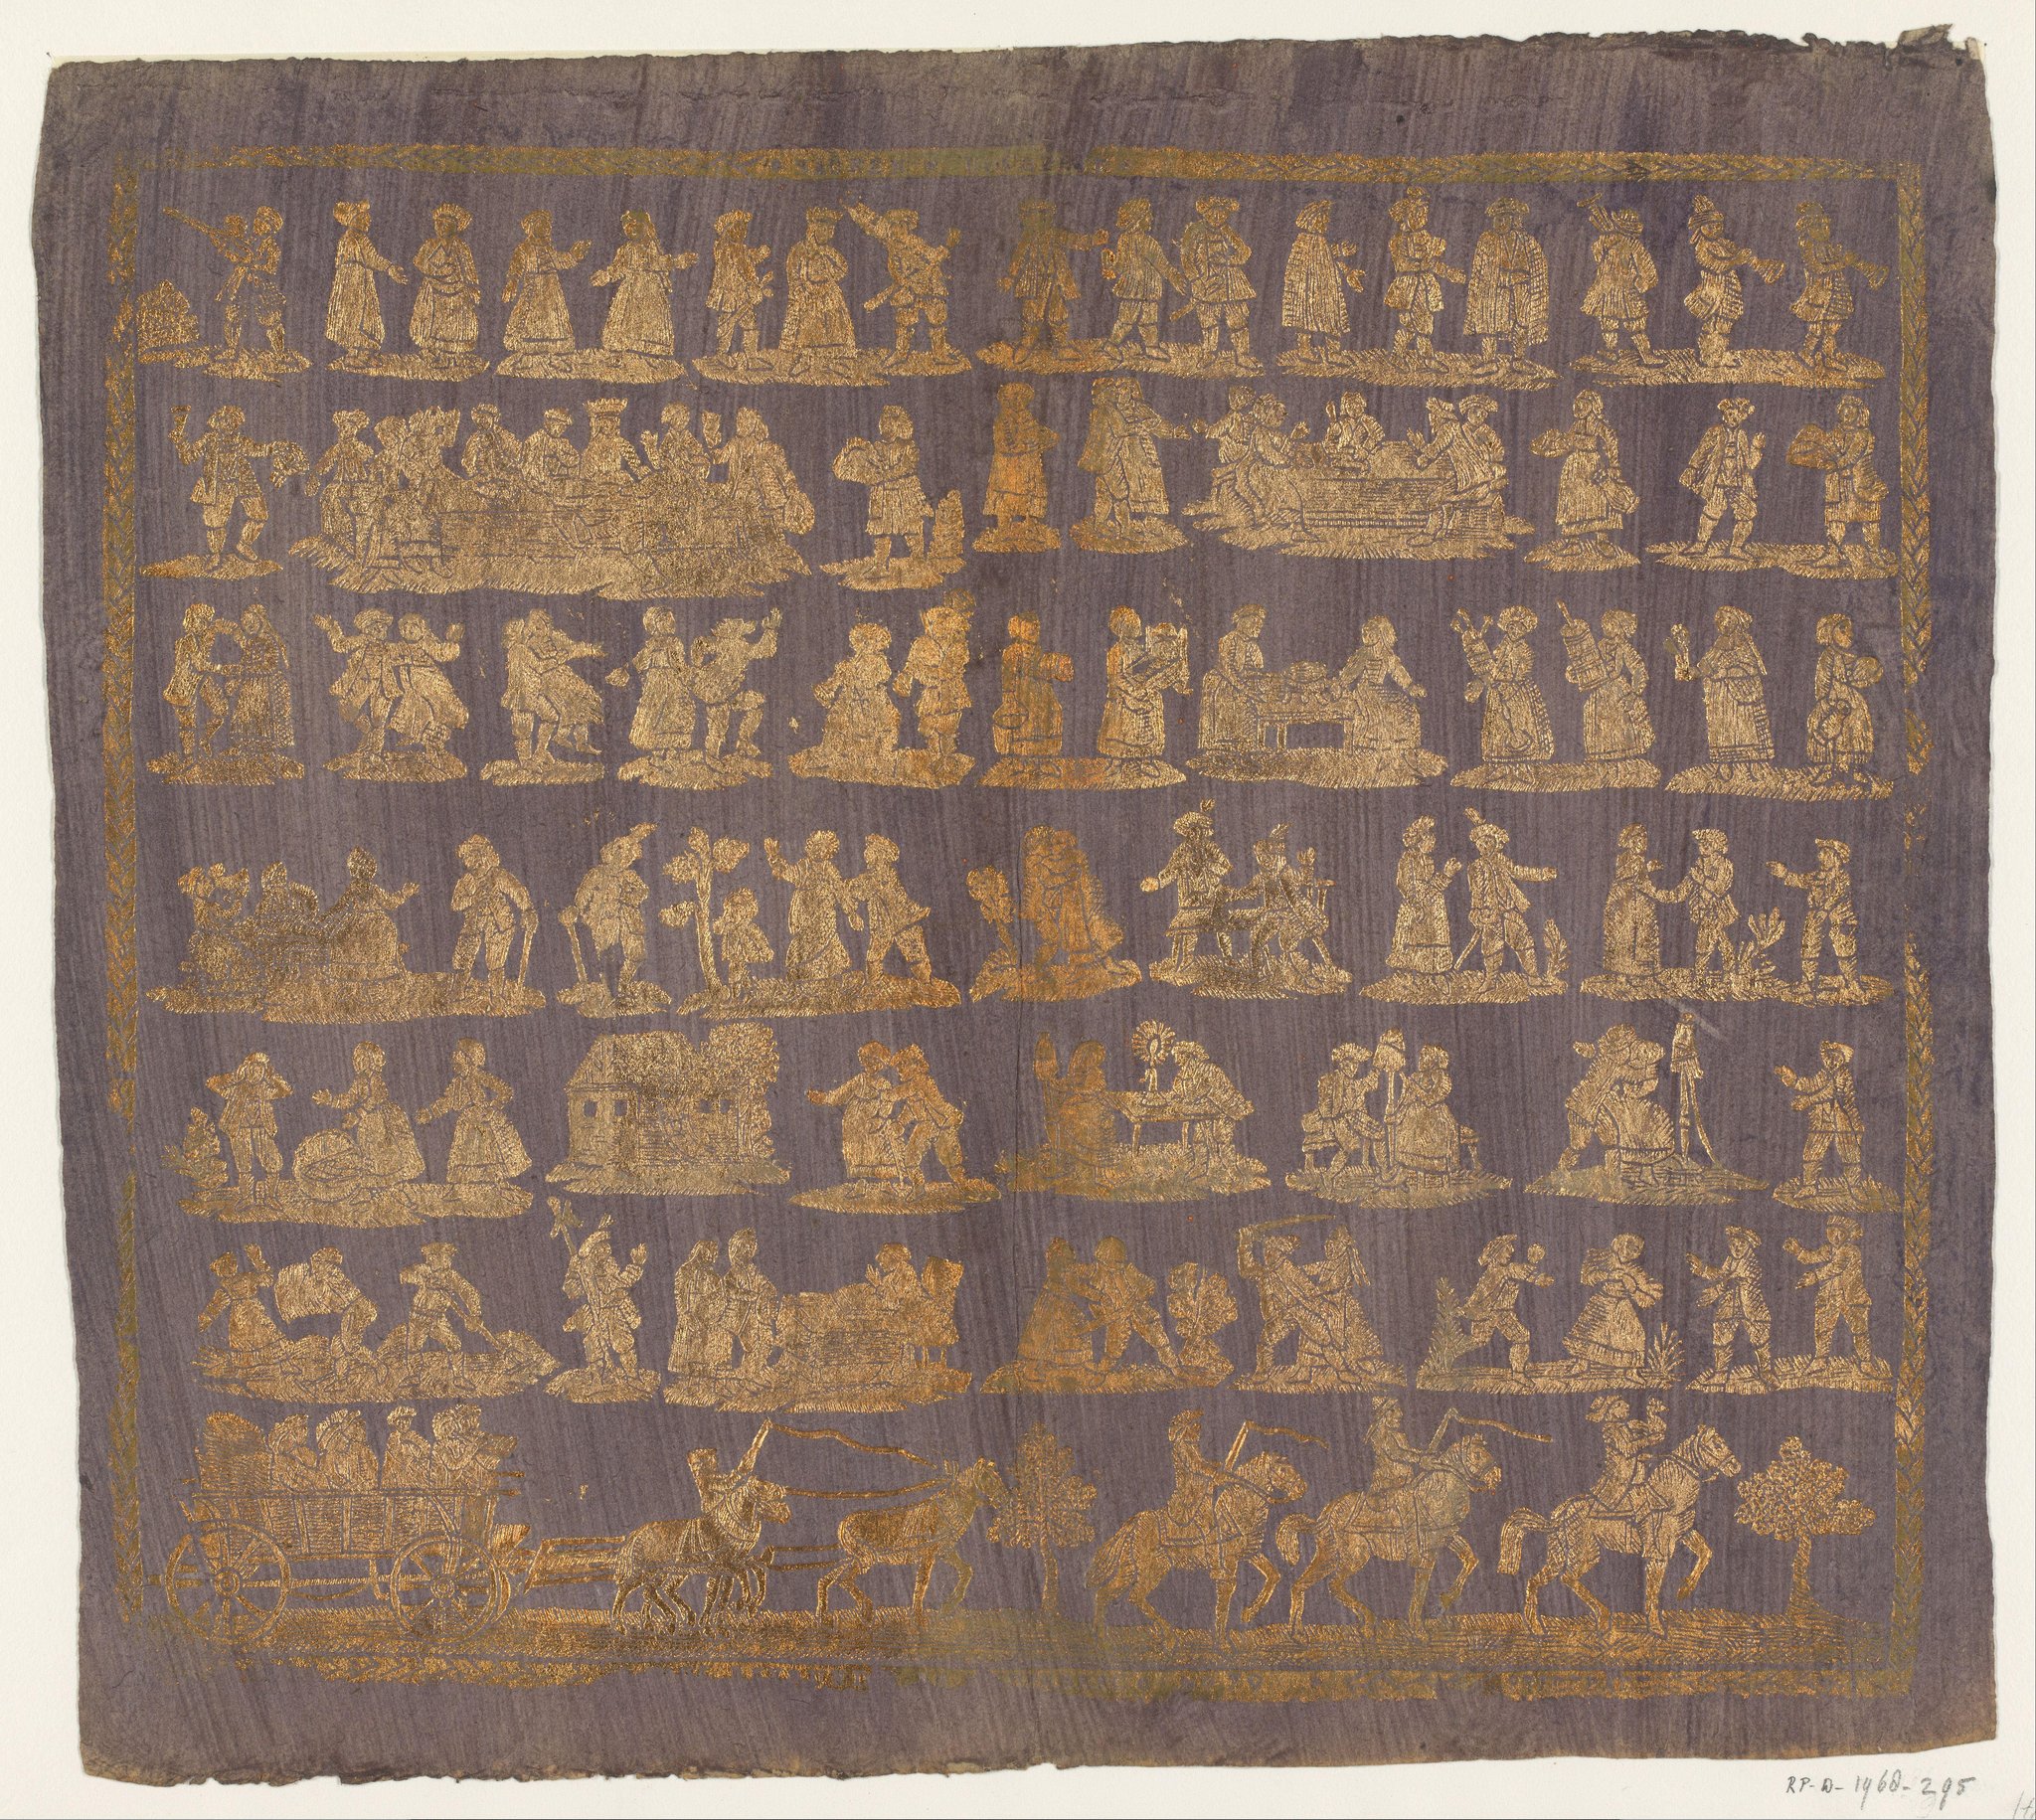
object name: brocade paper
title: Blad met scènes van het boerenleven in zeven rijen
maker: paul reimund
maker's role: sierpapiermaker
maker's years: 1764-1815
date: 1783-1815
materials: gold leaf, paint, paper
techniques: relief print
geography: nuremberg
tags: dancing, farmers, pleasure fair and circus, popular music, street music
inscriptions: collector's mark: Lugt 2228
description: Blad met scènes van het boerenleven in zeven rijen, linksboven muzikant, rechtsboven muzikant, linksonder door drie paarden getrokken boerenwagen met mensen, rechtsonder boom. Onderaan genummerd: 79.